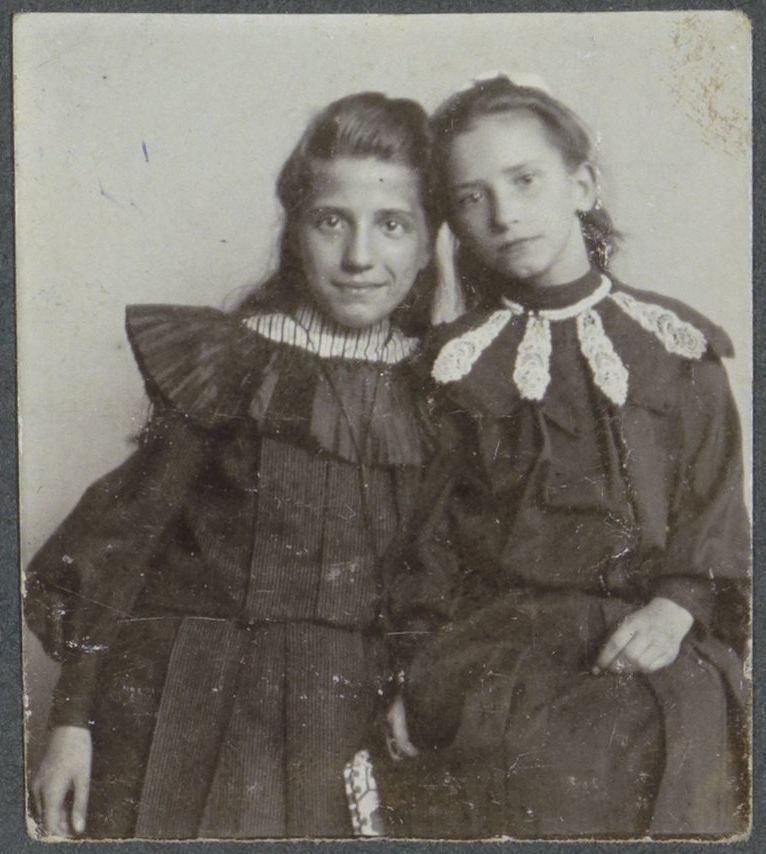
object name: photograph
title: Portret van twee meisjes, mogelijk zussen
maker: Anonymous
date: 1920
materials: cardboard, paper, photographic support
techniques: collodion silver print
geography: netherlands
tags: studio requisites ~ photographer, historical persons, sisters (second degree family relationships), netherlands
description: Onderdeel van Fotoalbum met portretten vervaardigd door Nederlandse studio's waaronder automaatfoto's.